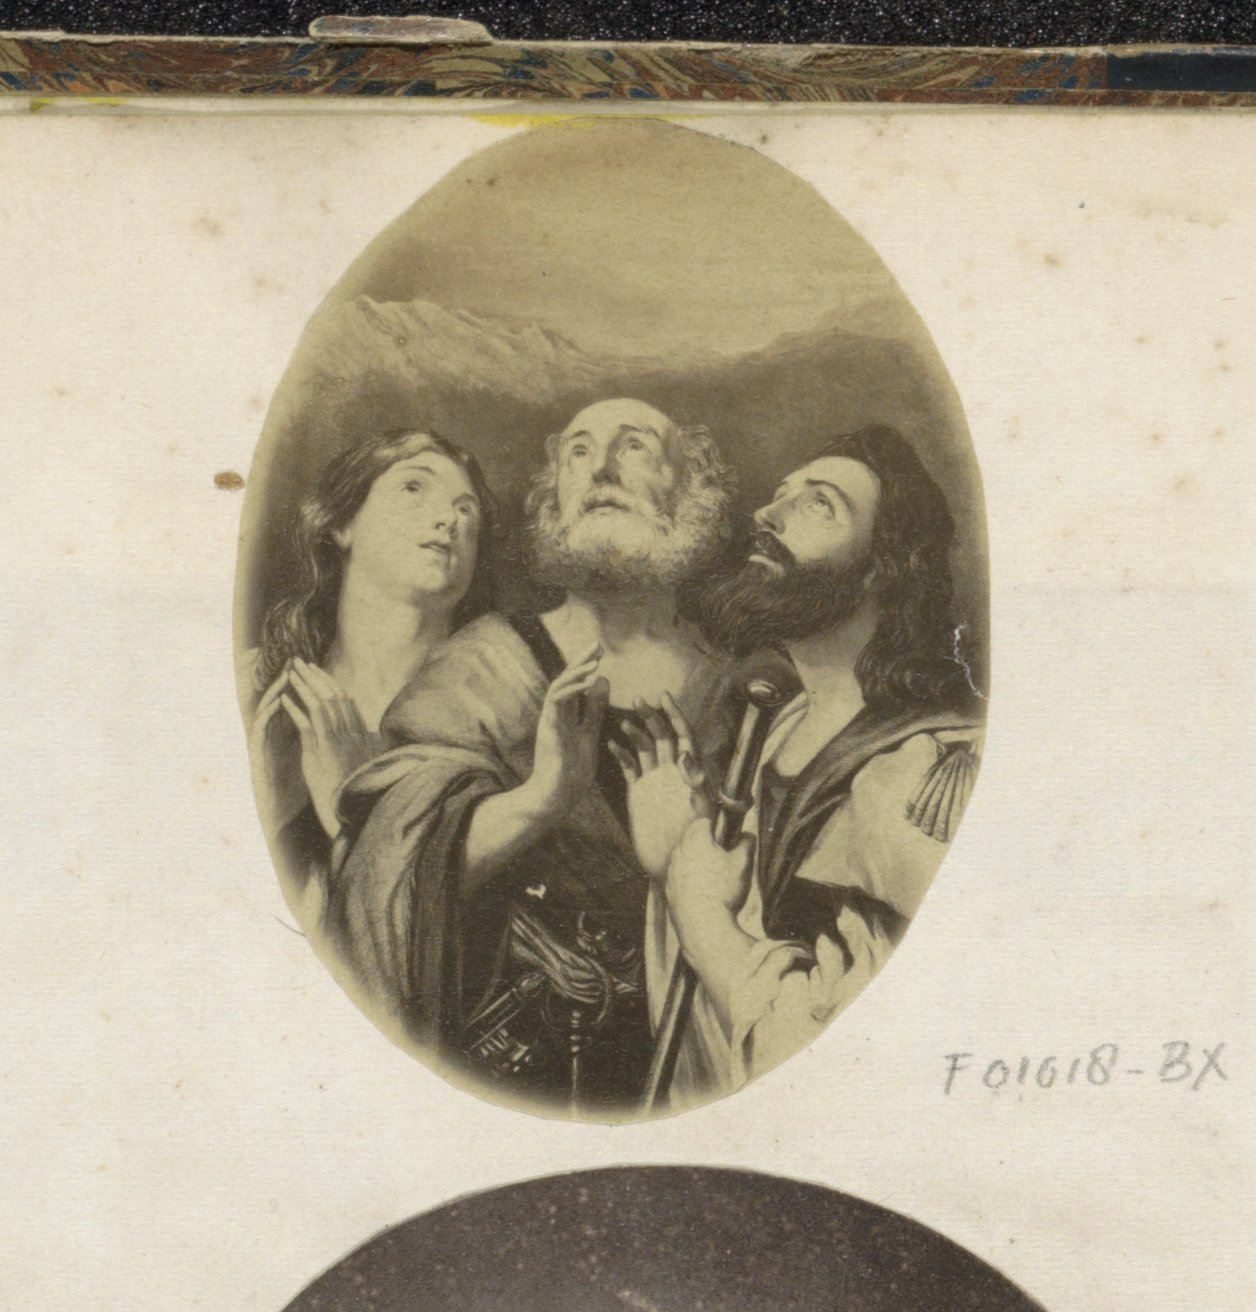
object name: reproduction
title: Fotoreproductie van (vermoedelijk) een schilderij met de apostel Petrus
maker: Anonymous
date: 1860-1870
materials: paper, photographic support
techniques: albumen print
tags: life and acts of peter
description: Onderdeel van Engels familiealbum met foto's van personen, reizen, cricket en kunstwerken.